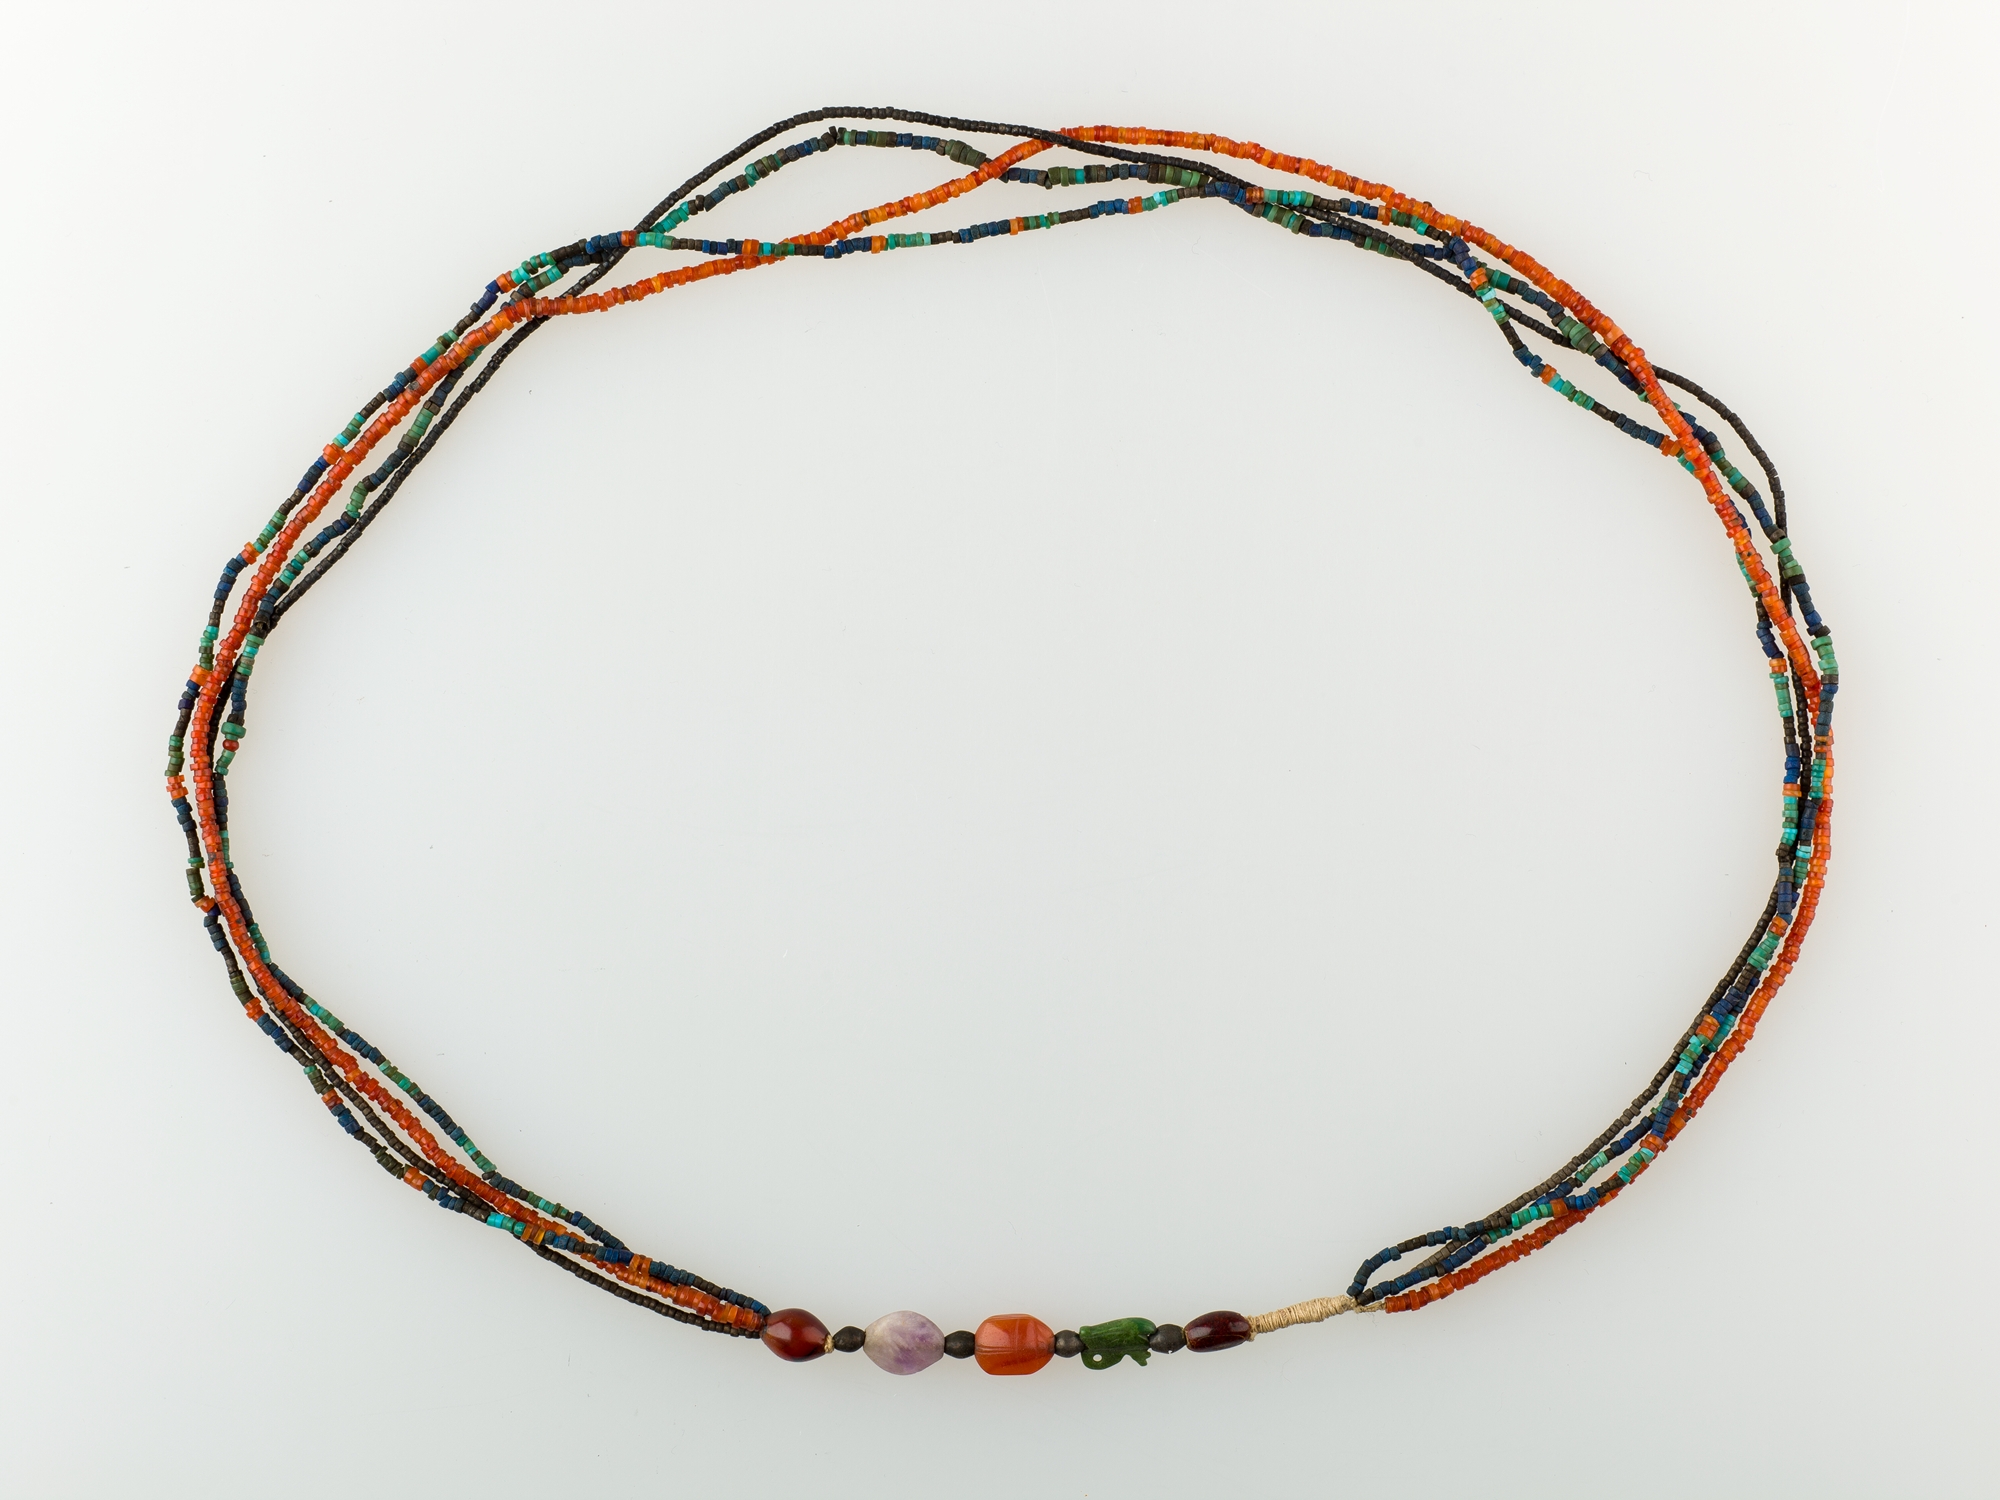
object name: necklace, myt, mayet, amulet, wadjet eye, scarab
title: A Necklace of four strands of beads and amulets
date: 2051-2030 BCE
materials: gemstone, faience, silver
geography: egypt